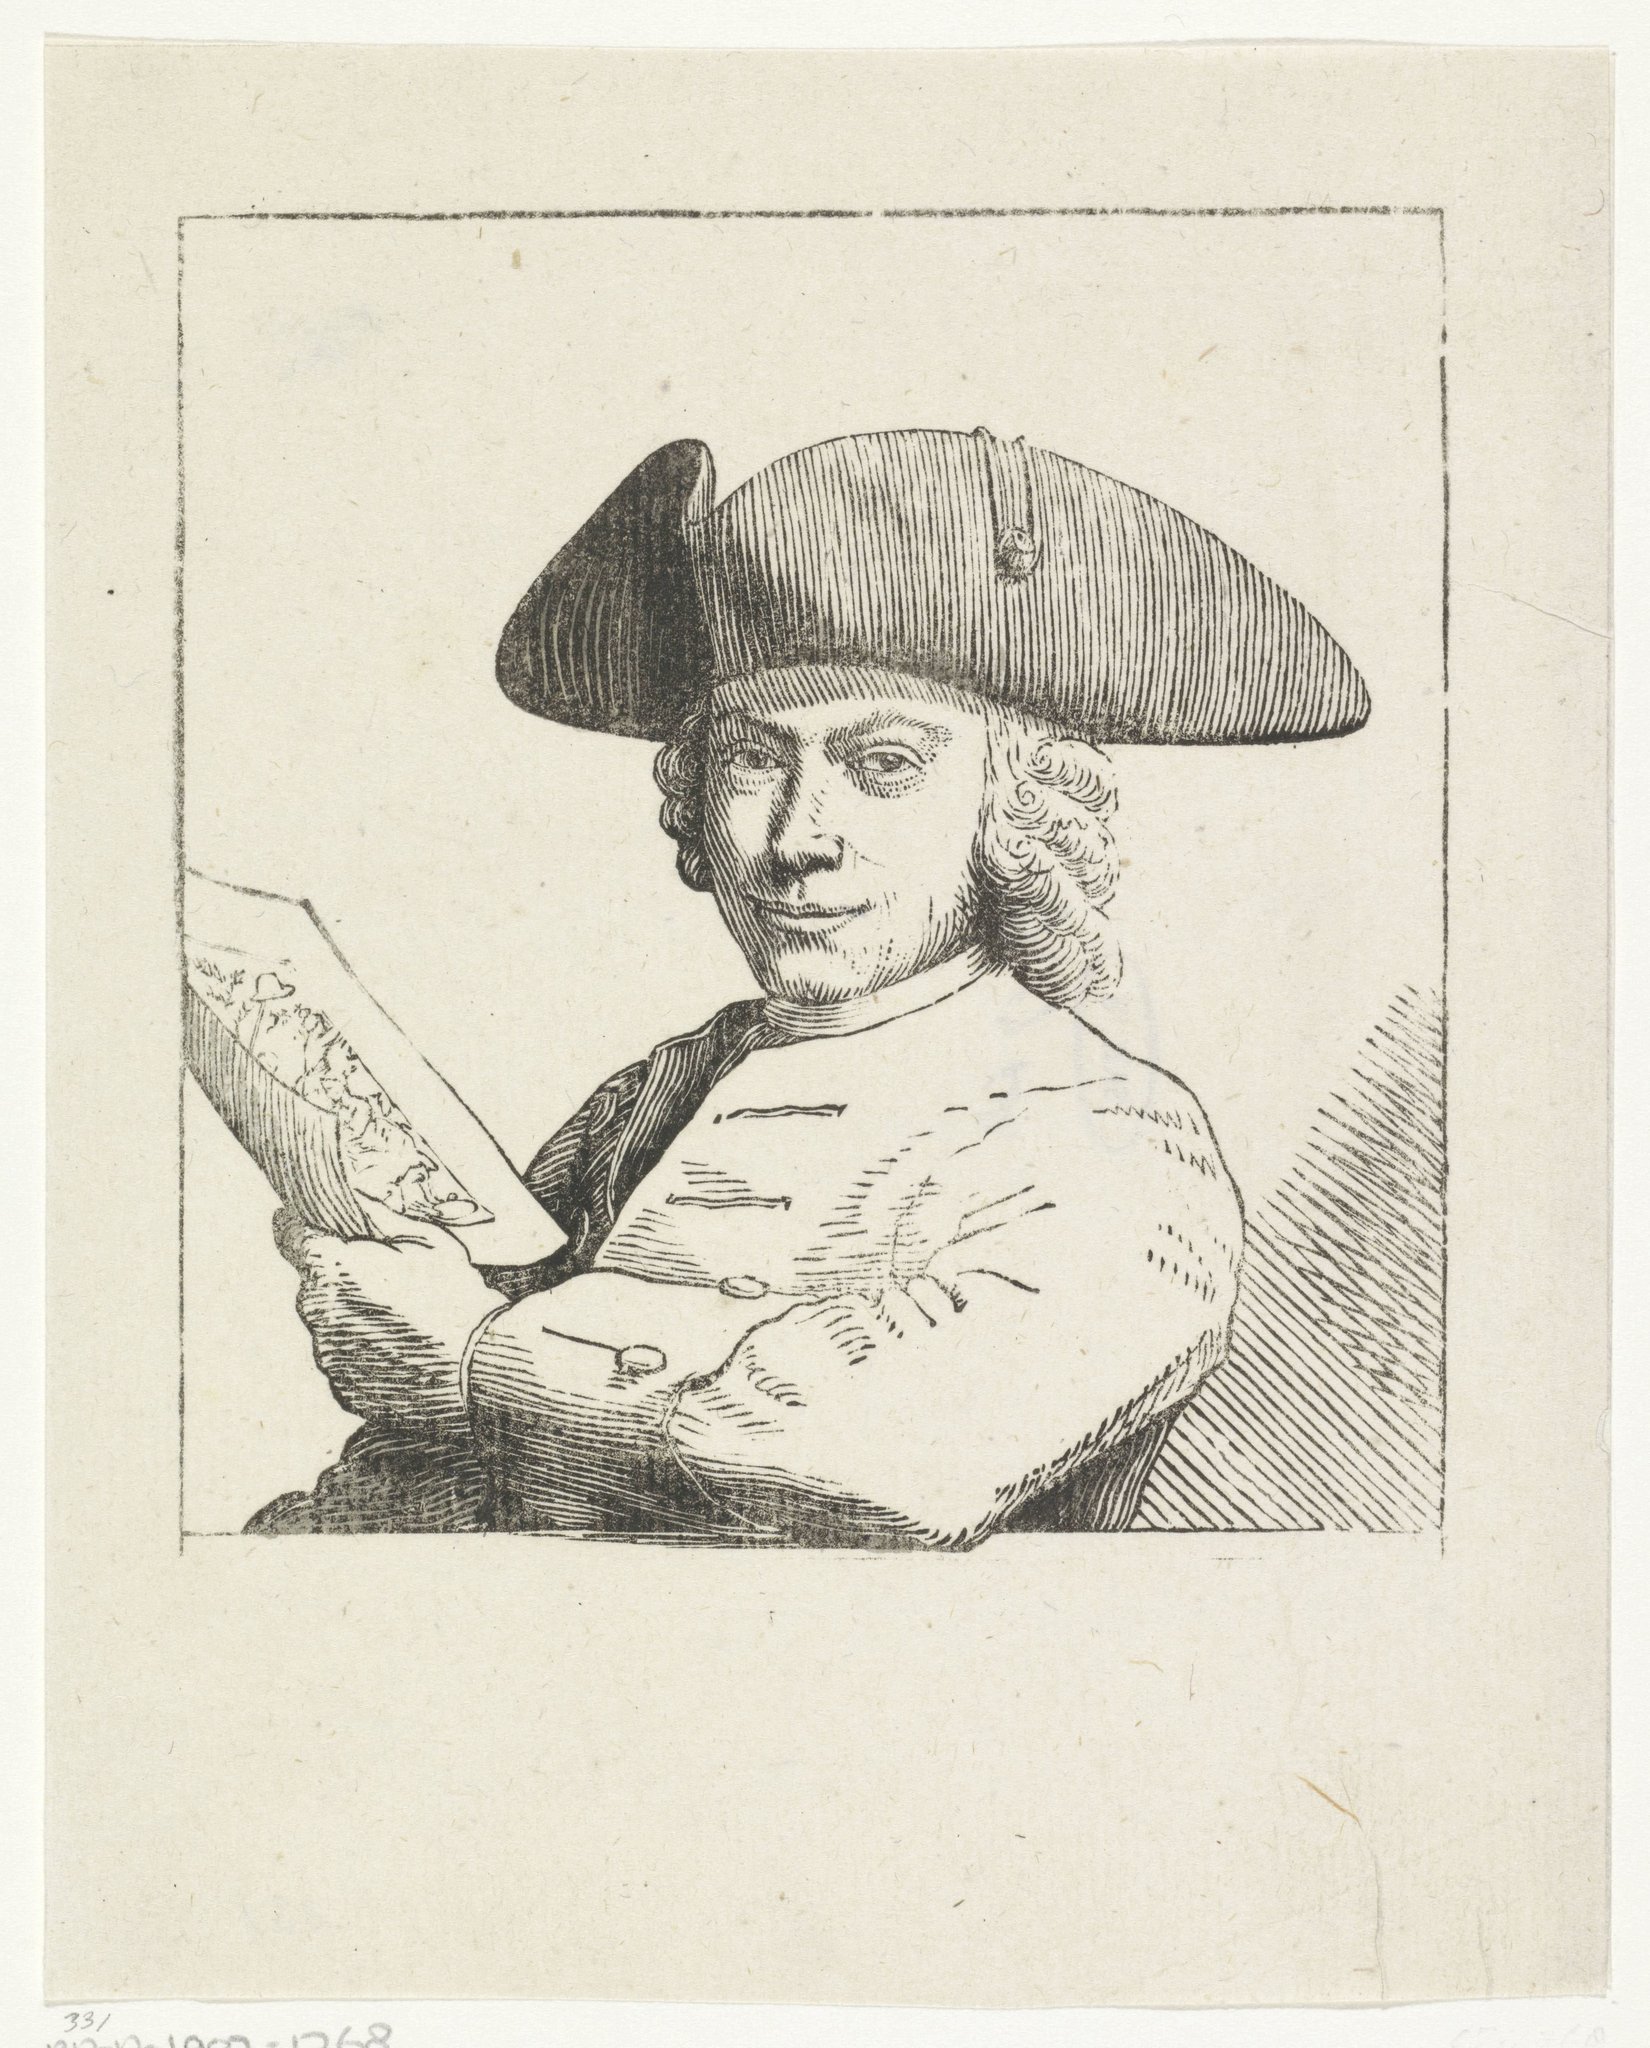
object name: print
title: Zelfportret van Cornelis van Noorde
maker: cornelis van noorde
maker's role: draughtsman, print maker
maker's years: 1731-1795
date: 1763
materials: paper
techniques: woodcut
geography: haarlem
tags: haarlem, print maker, draughtsman, cornelis van noorde, portrait, self-portrait of artist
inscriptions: collector's mark: Lugt 2228